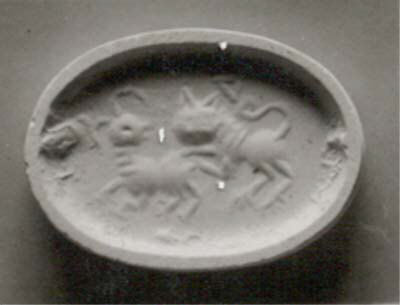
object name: stamp seal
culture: sasanian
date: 201-700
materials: stone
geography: iran or mesopotamia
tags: animals